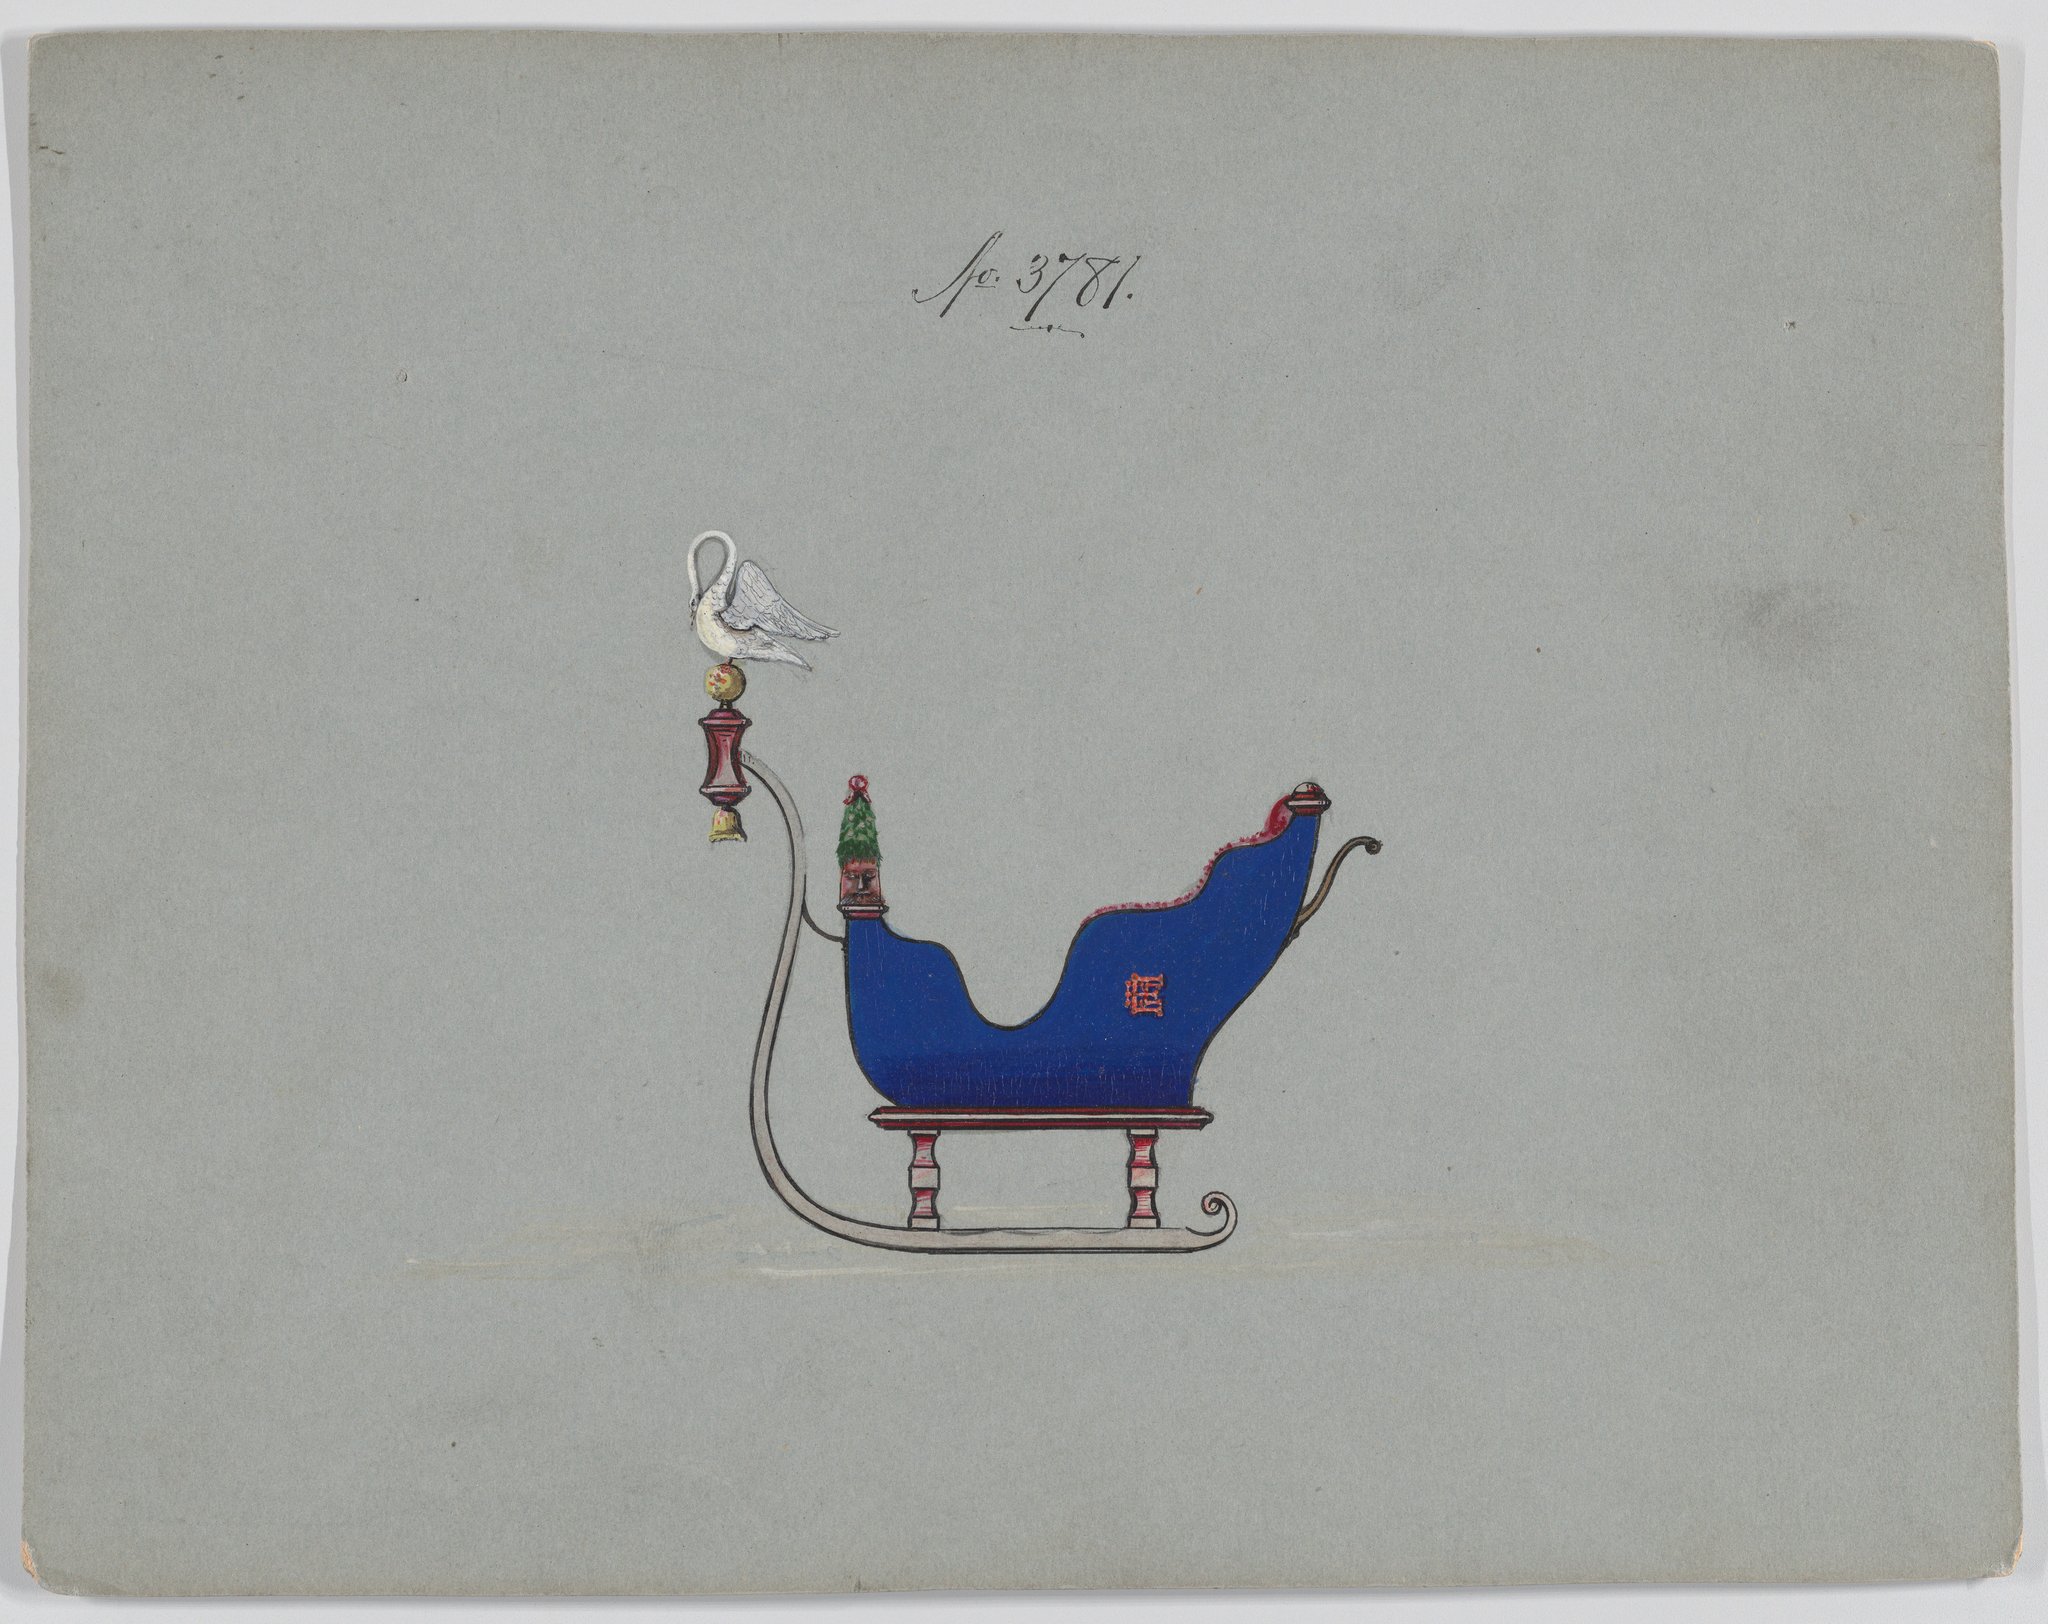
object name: drawing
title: Push Sleigh #3781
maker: brewster & co.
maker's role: manufacturer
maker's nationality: american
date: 1882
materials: gouache, gum arabic, ink, watercolor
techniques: pen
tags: sleighs